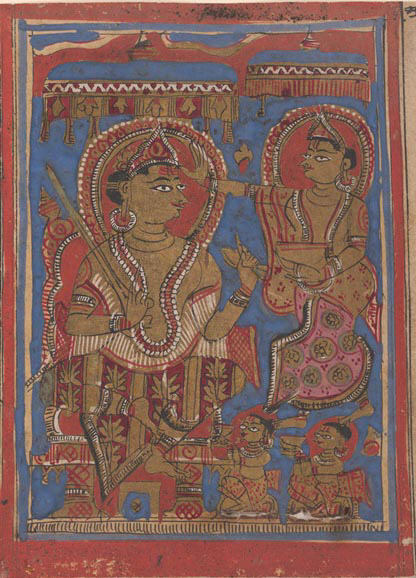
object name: folio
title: King Siddharta Being Anointed: Folio from a Kalpasutra Manuscript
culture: indian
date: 1401-1500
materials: gold, ink, paper, watercolor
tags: kings,men,women